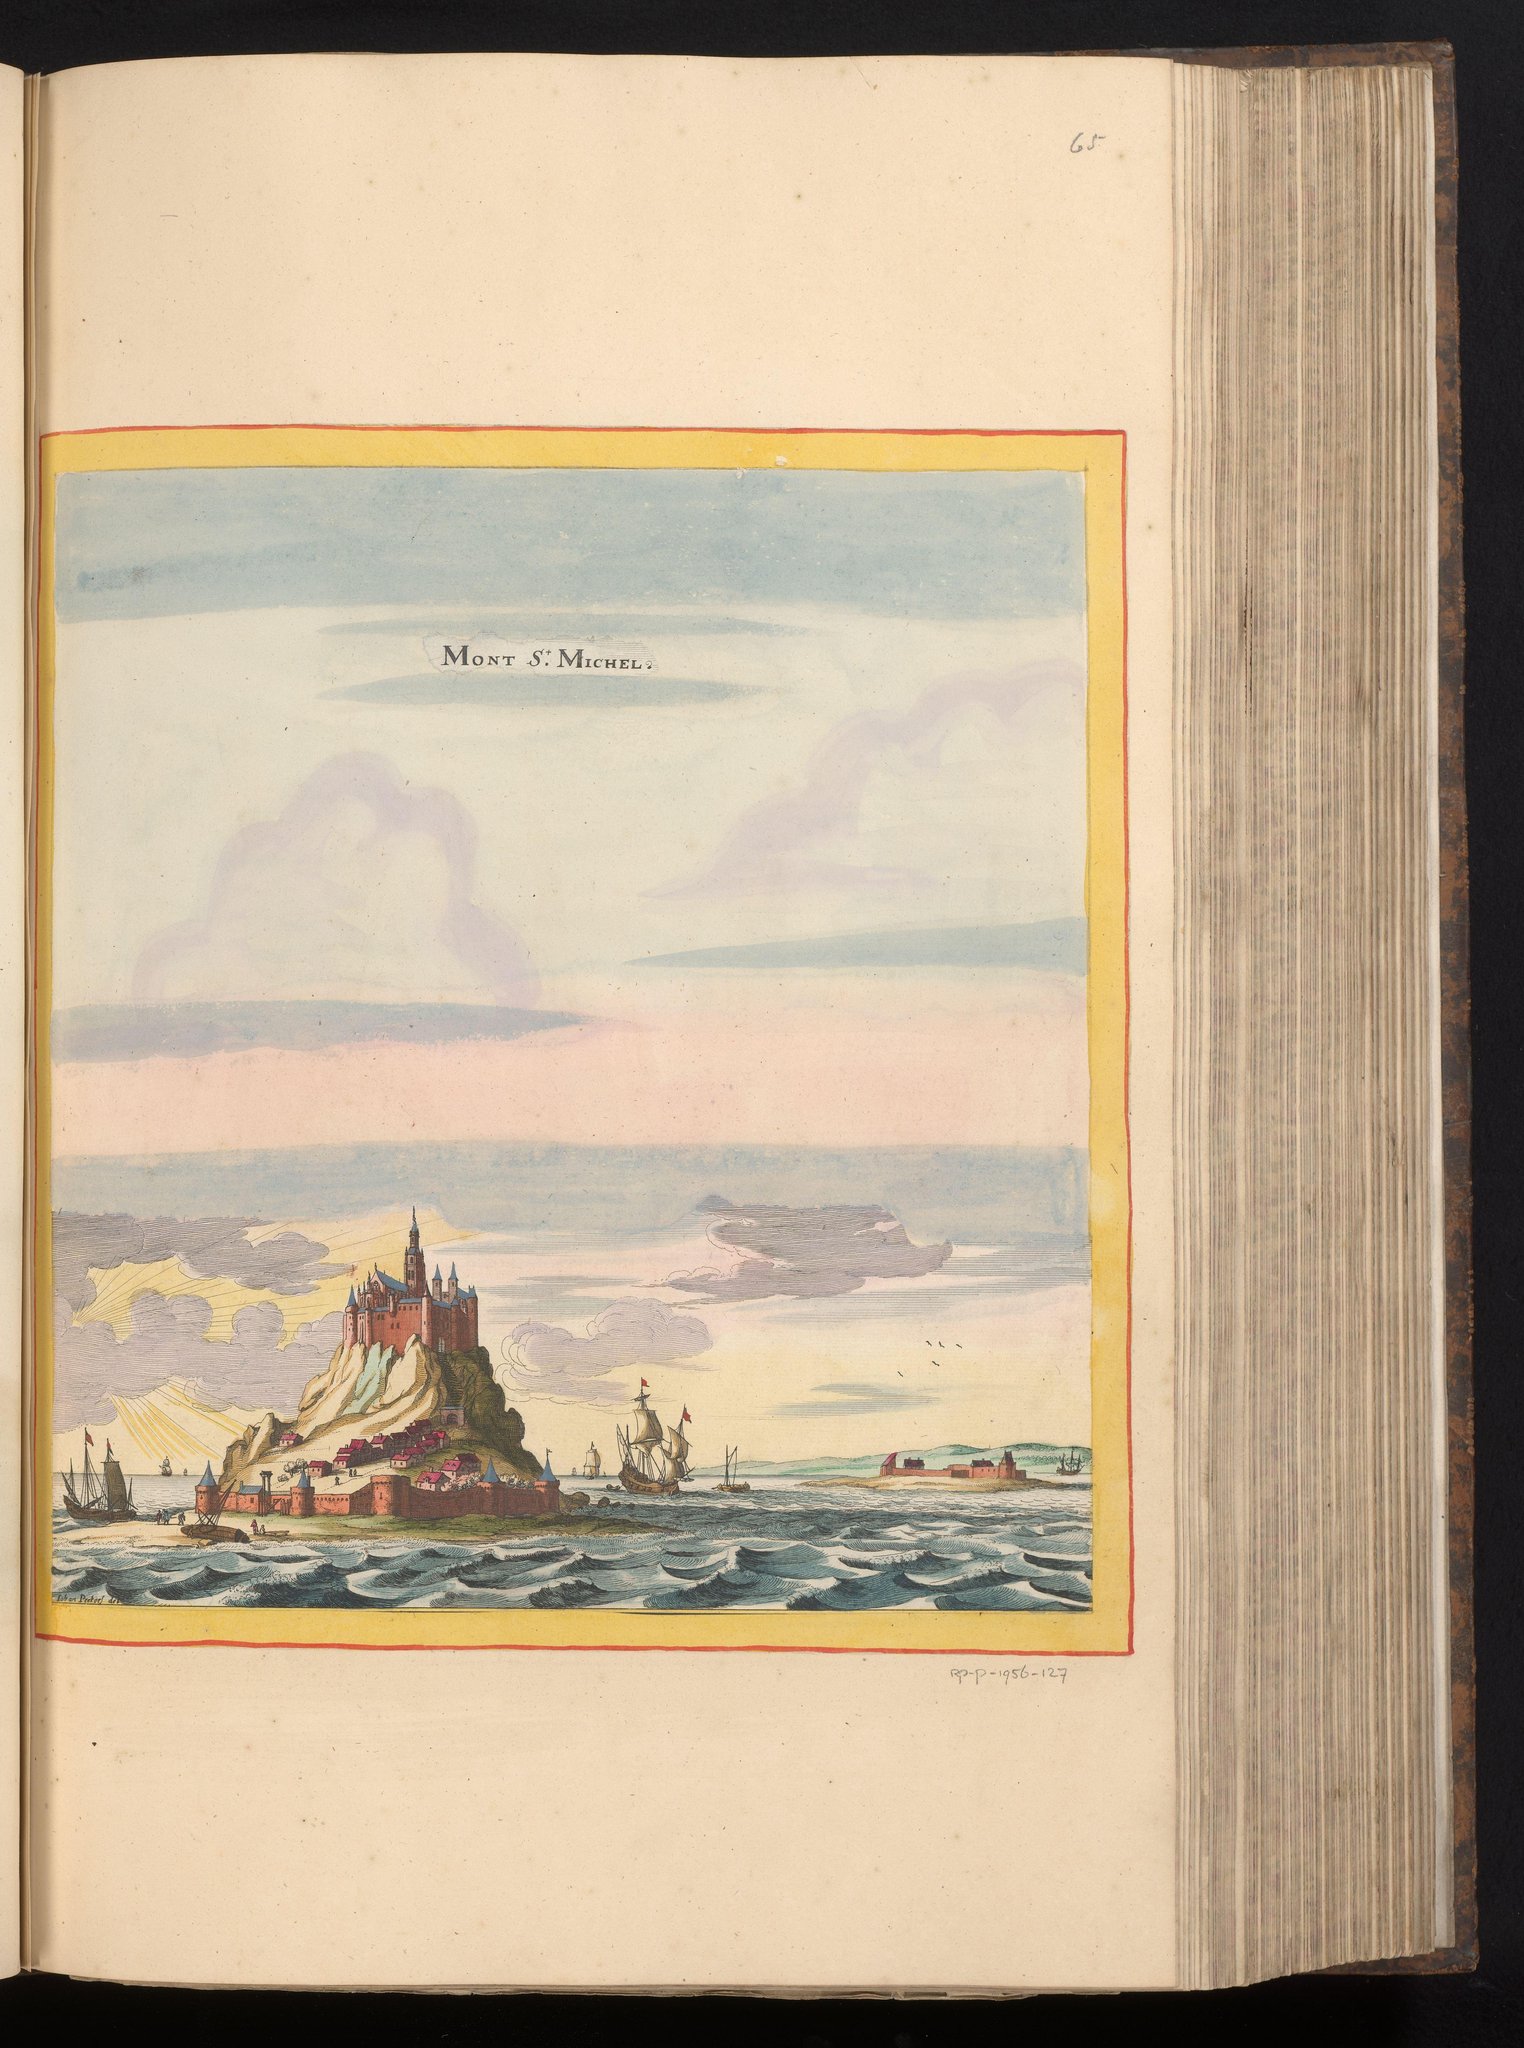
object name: album leaf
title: Gezicht op Mont Saint-Michel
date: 1657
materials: paper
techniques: engraving, etching, hand coloring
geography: the hague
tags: village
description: Prent uit: Zeiller, Martin. Topographia Galliae. 13 dln. Frankfurt: Caspar Merian, 1657, dl. 8, na p. 20. De titel is uit de originele prent gesneden. Boven de gravure is een deel lucht en wolken (bij)geschilderd, waarin de titel gelijmd is. Origineel op één blad gedrukt met het gezicht op Lisieux (RP-P-1956-125).